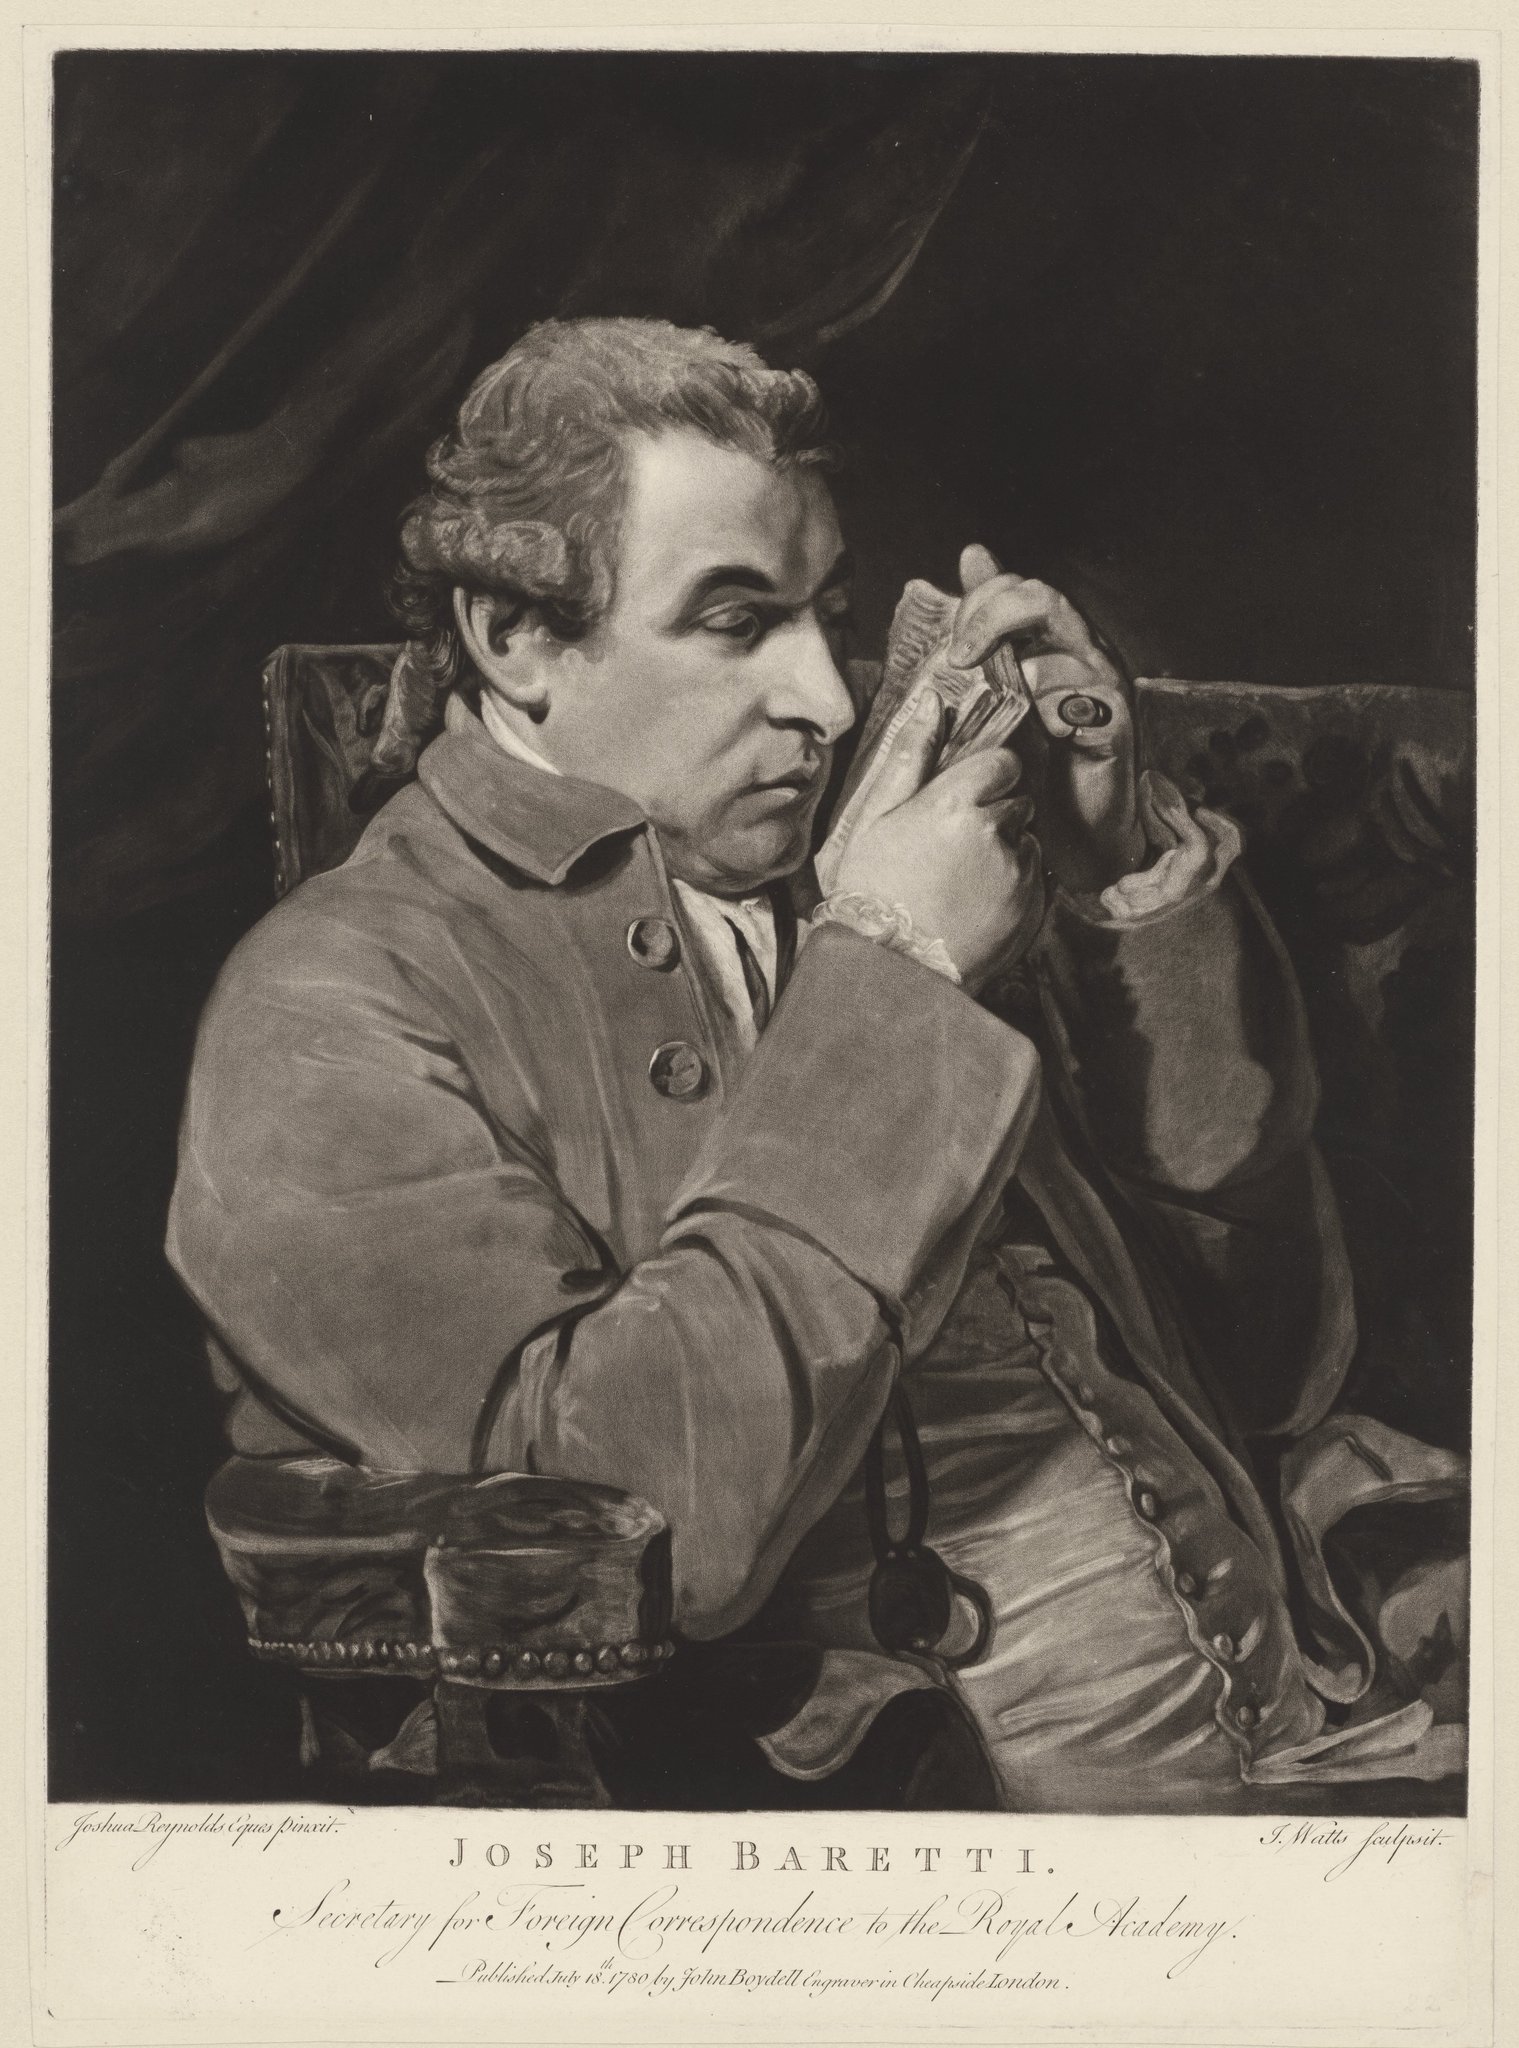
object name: print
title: Portret van Giuseppe Marc'Antonio Baretti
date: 1780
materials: paper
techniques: mezzotint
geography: london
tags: london, giuseppe marc'antonio baretti, reading, historical persons, portrait of a writer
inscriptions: collector's mark: Lugt 240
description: Na zijn jeugd in Italië ging Baretti naar Engeland waar hij van 1751 tot 1760 verbleef en werd toegelaten tot de Royal Academy.